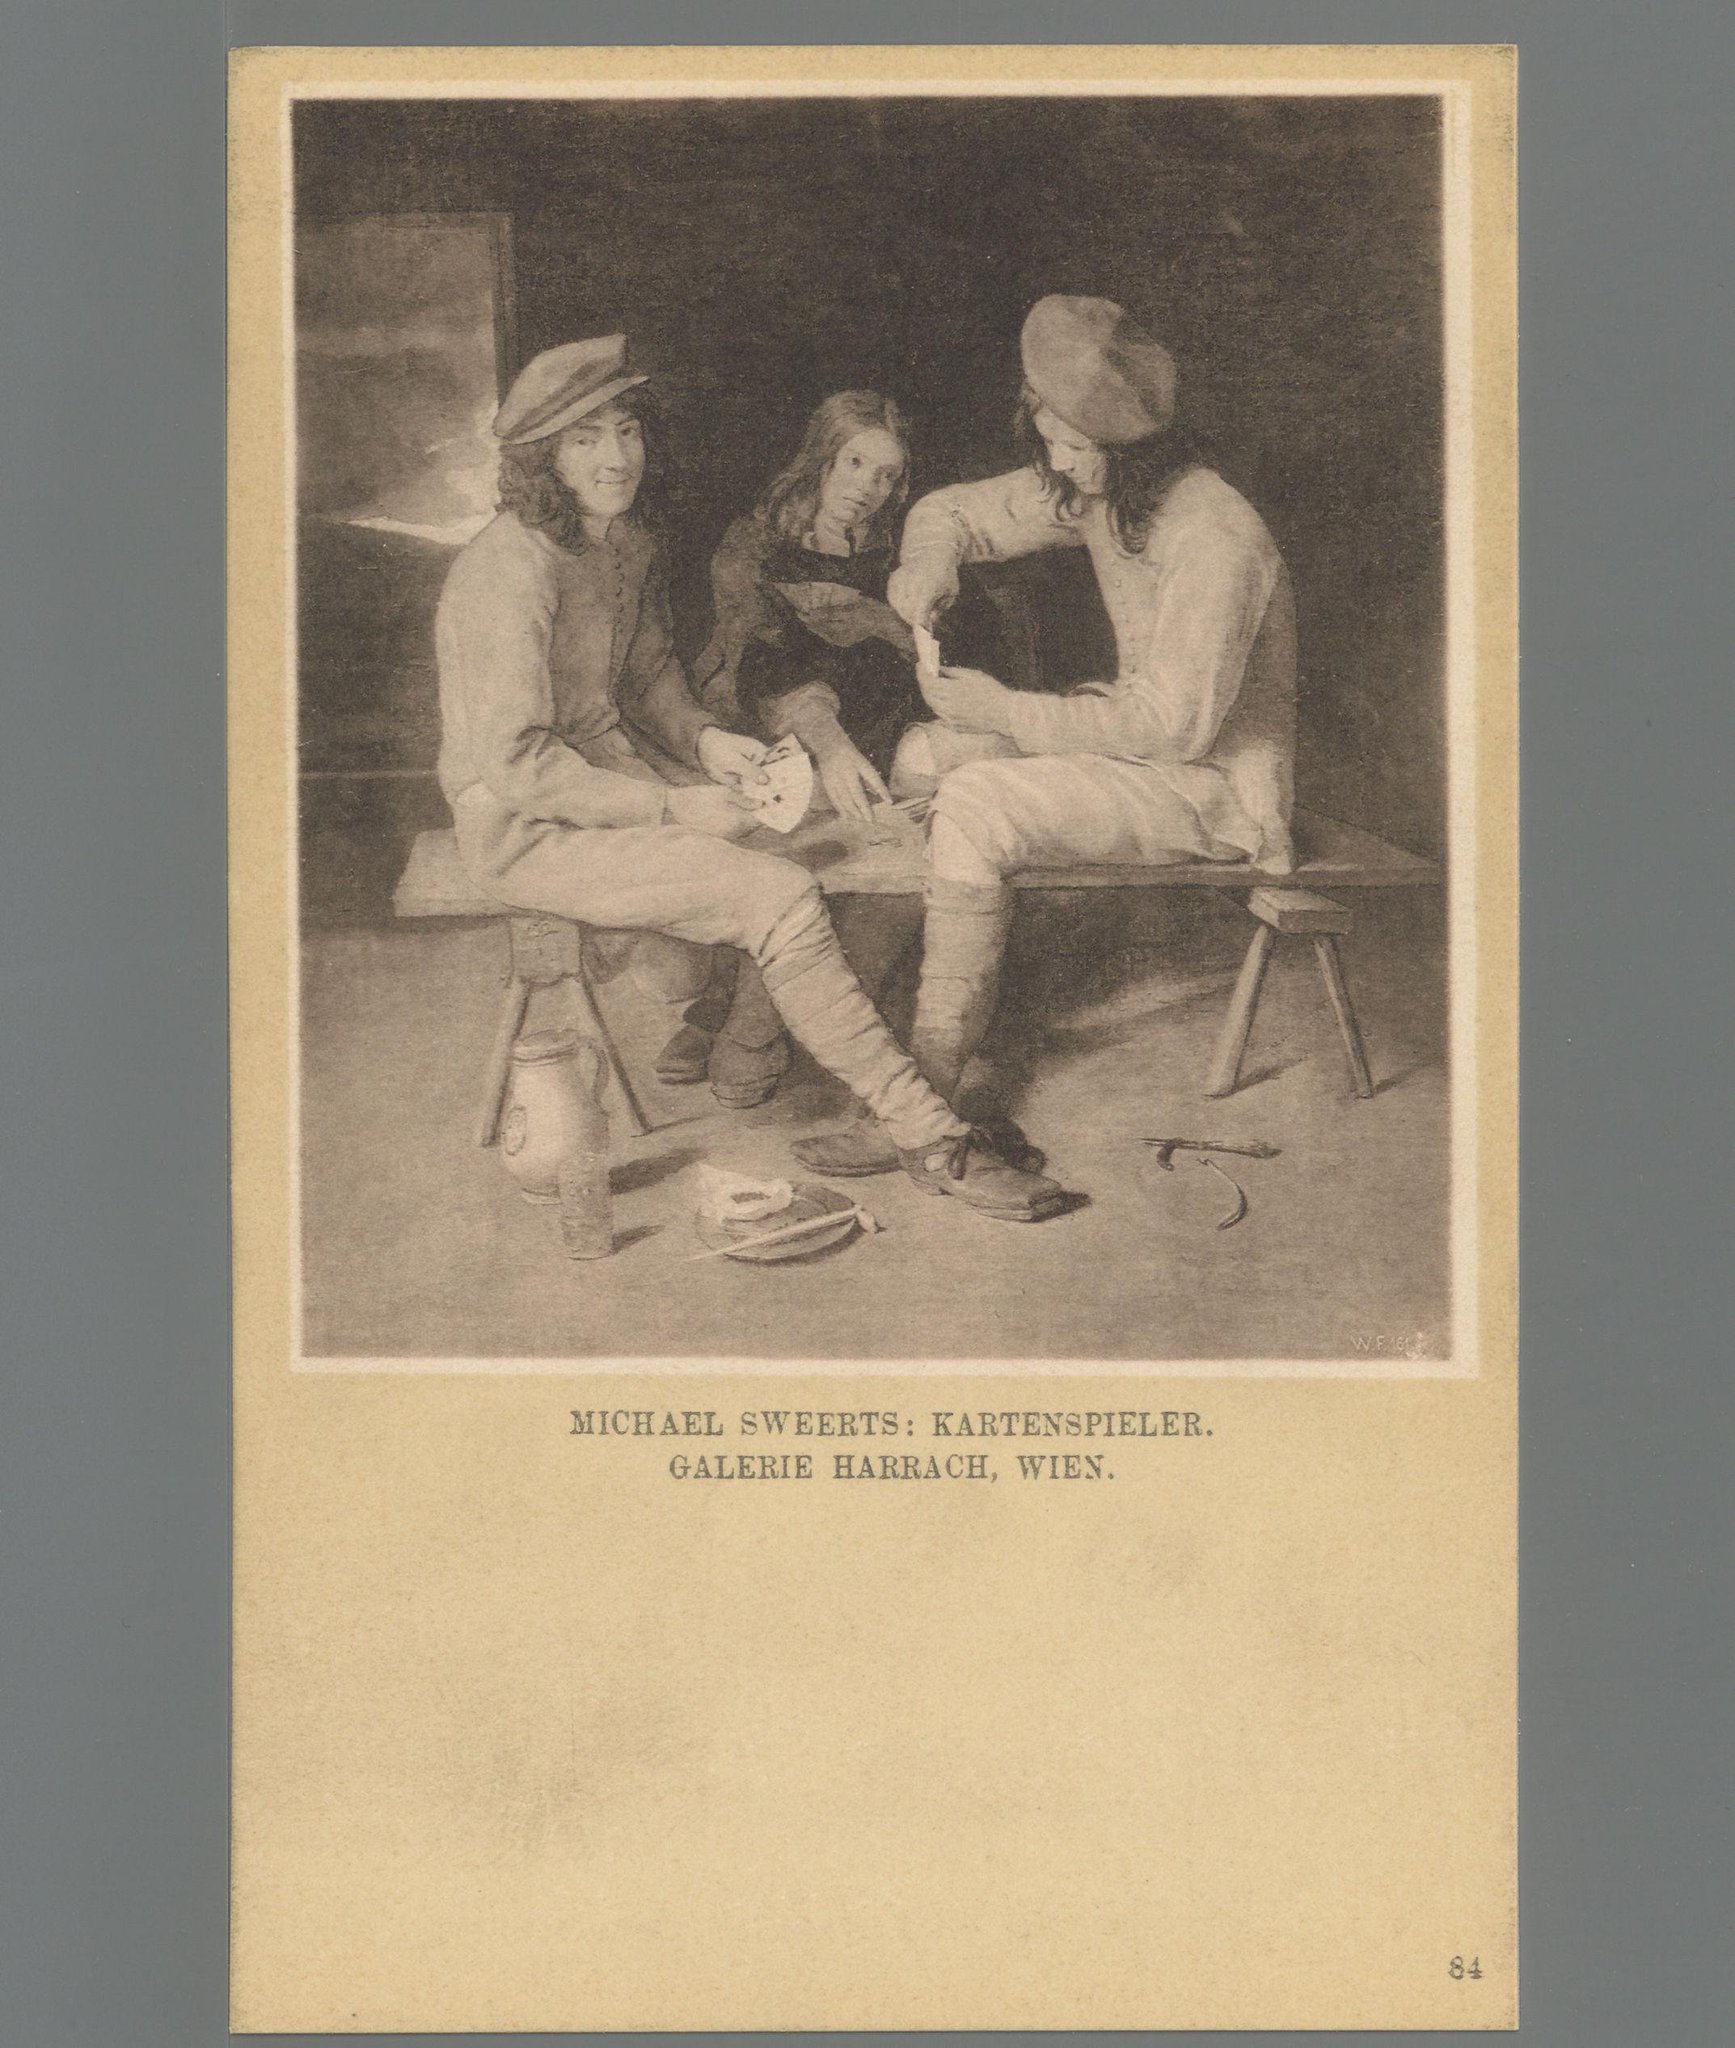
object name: photomechanical print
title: Michael Sweerts: Kartenspieler. Galerie Harrach, Wien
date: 1906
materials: cardboard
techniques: photograph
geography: vienna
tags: adult man (+ two persons), playing-cards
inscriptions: date